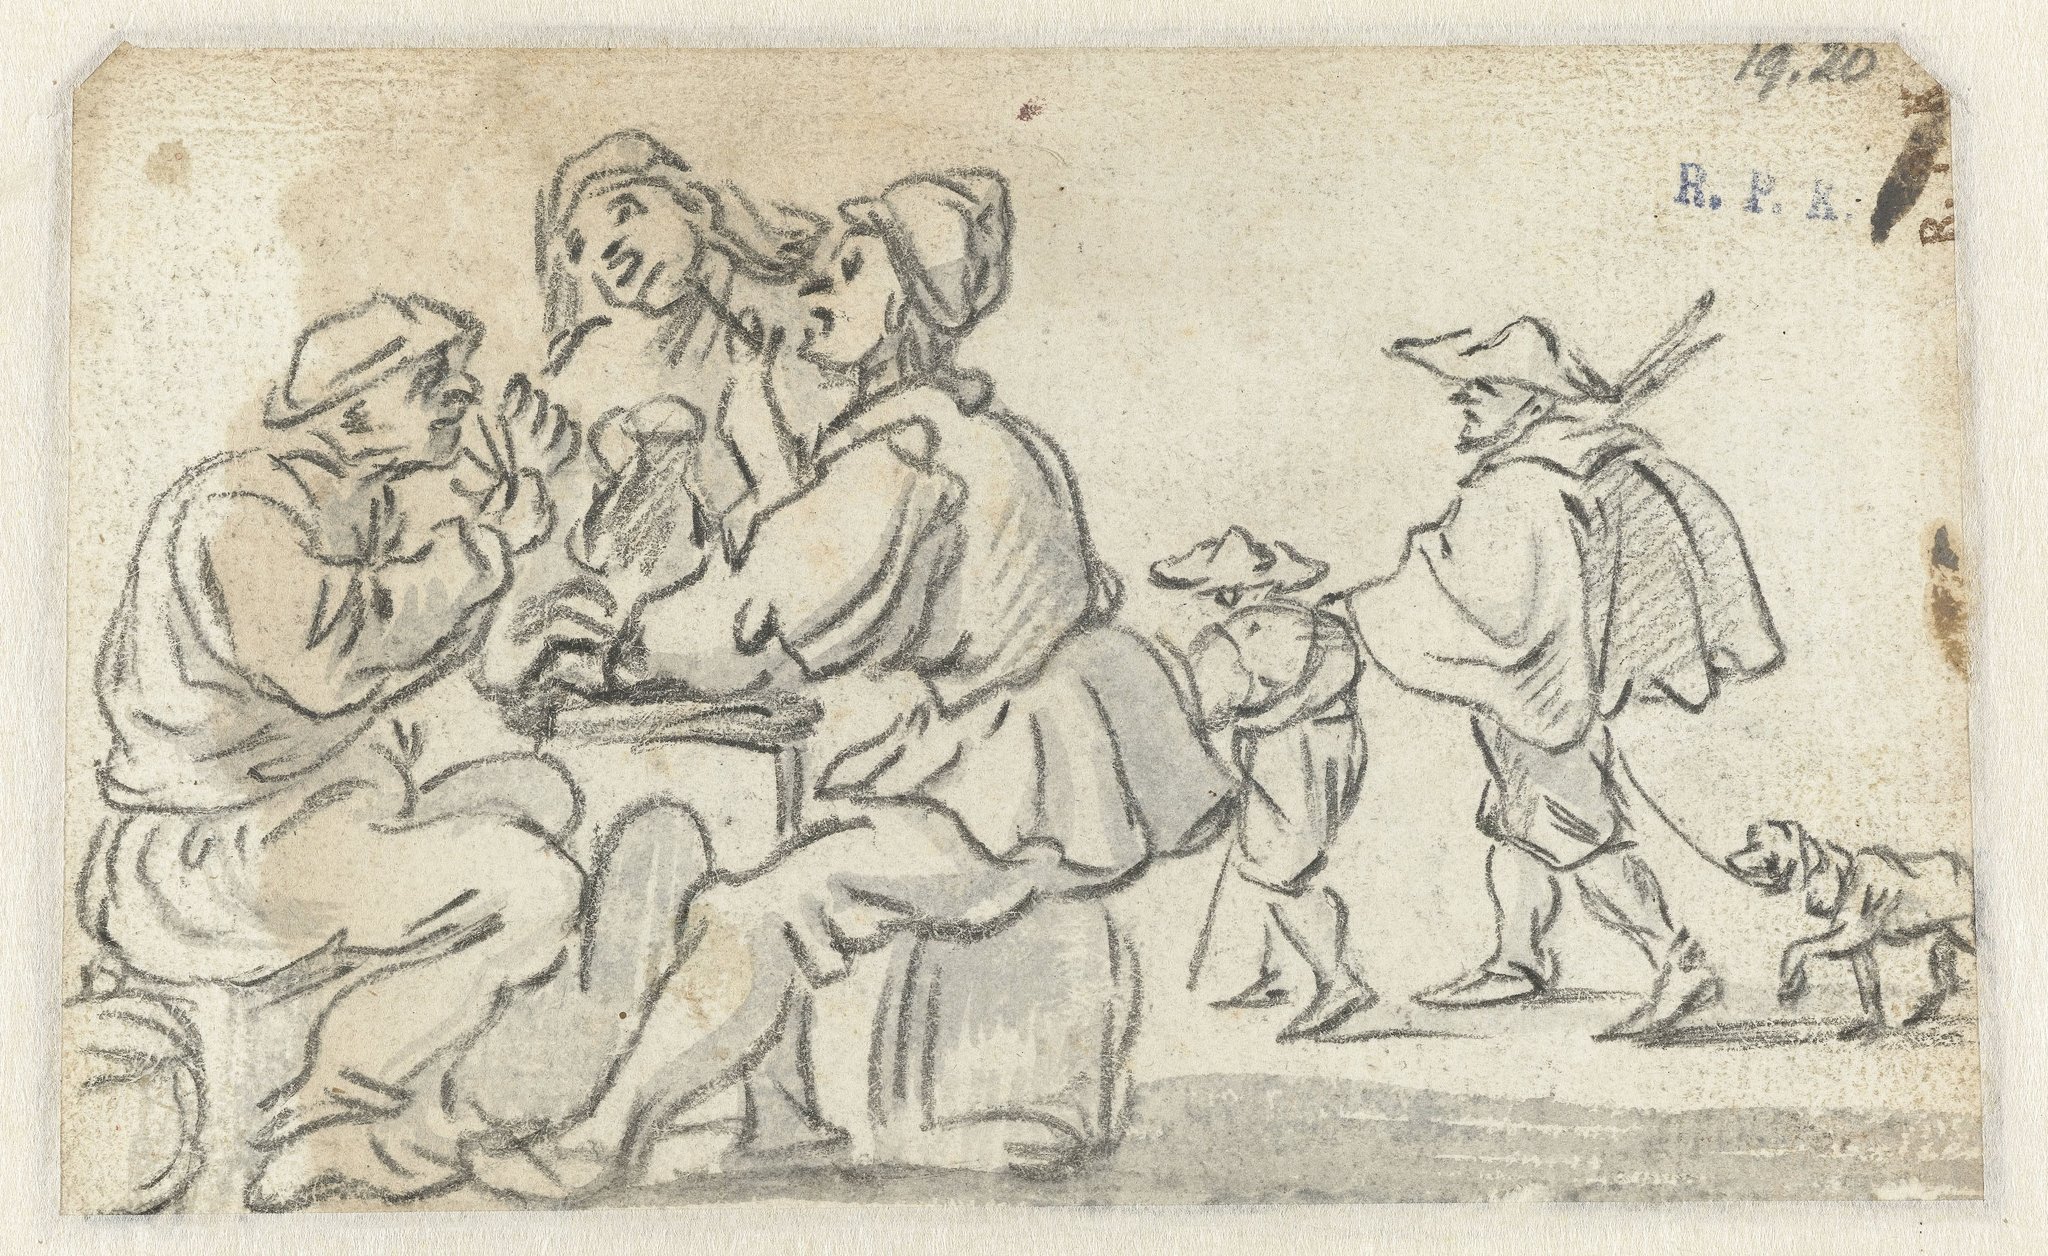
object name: drawing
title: Drie boeren aan een tafel en een man met een hond begeleid door een jongen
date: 1600-1630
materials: chalk, ink, paper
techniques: pen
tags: inn, coffee-house, public house, etc., blind, blindness, farmers, dog (with name of kind)